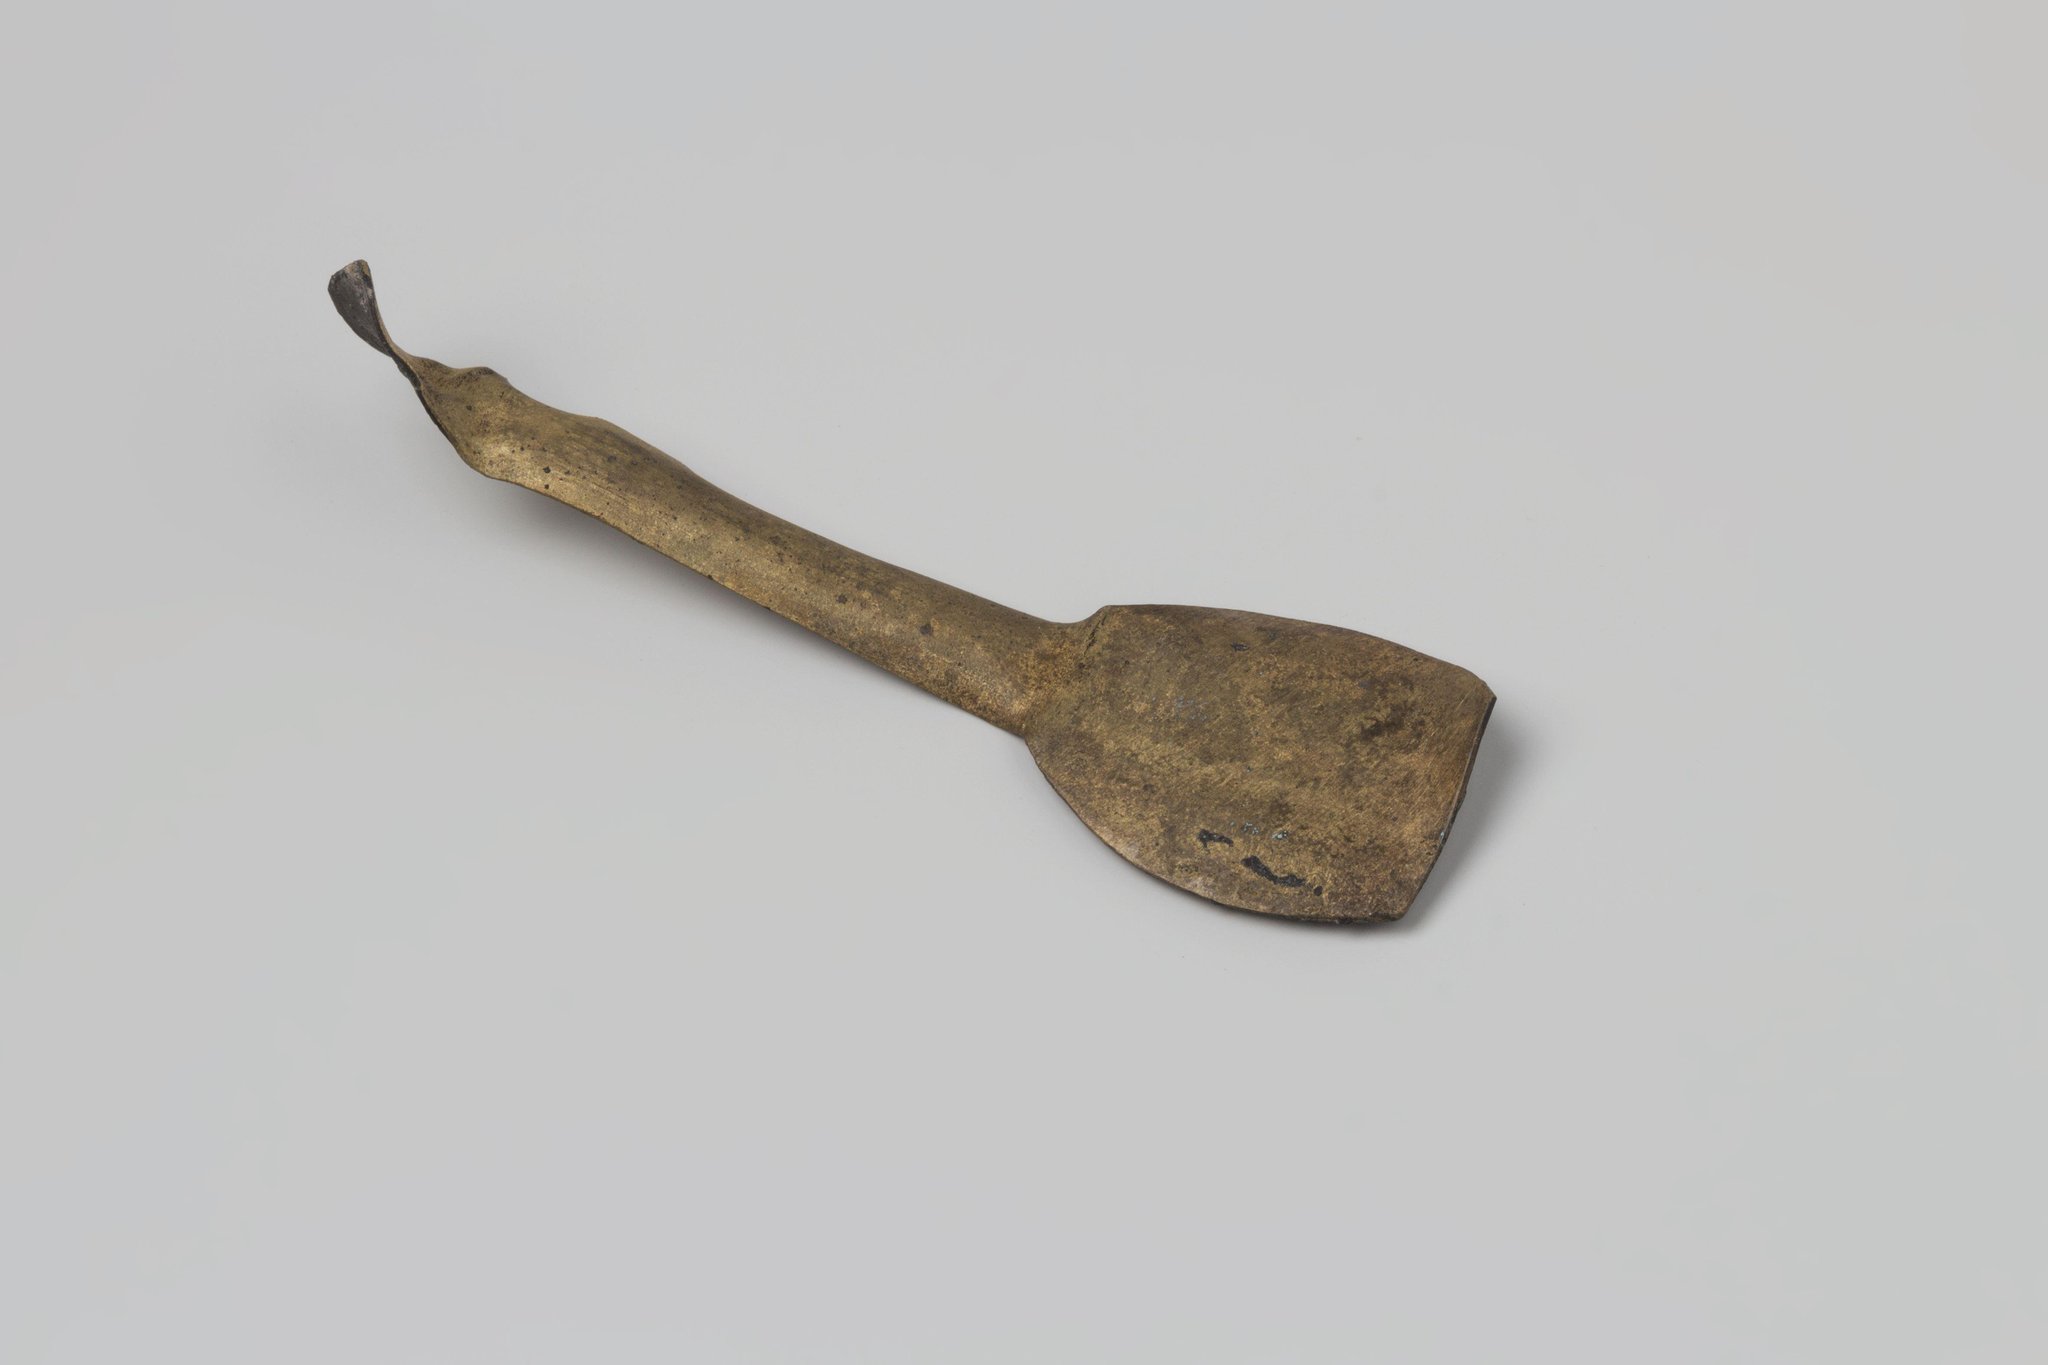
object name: toets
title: Toets uit het wrak van de Oost-Indiëvaarder 't Vliegend Hart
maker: Anonymous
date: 1700-1735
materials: brass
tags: 't vliegend hart (schip), verenigde oostindische compagnie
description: Messingen toets, licht verbogen, in de vorm van een steel met een ronde schep. Key.